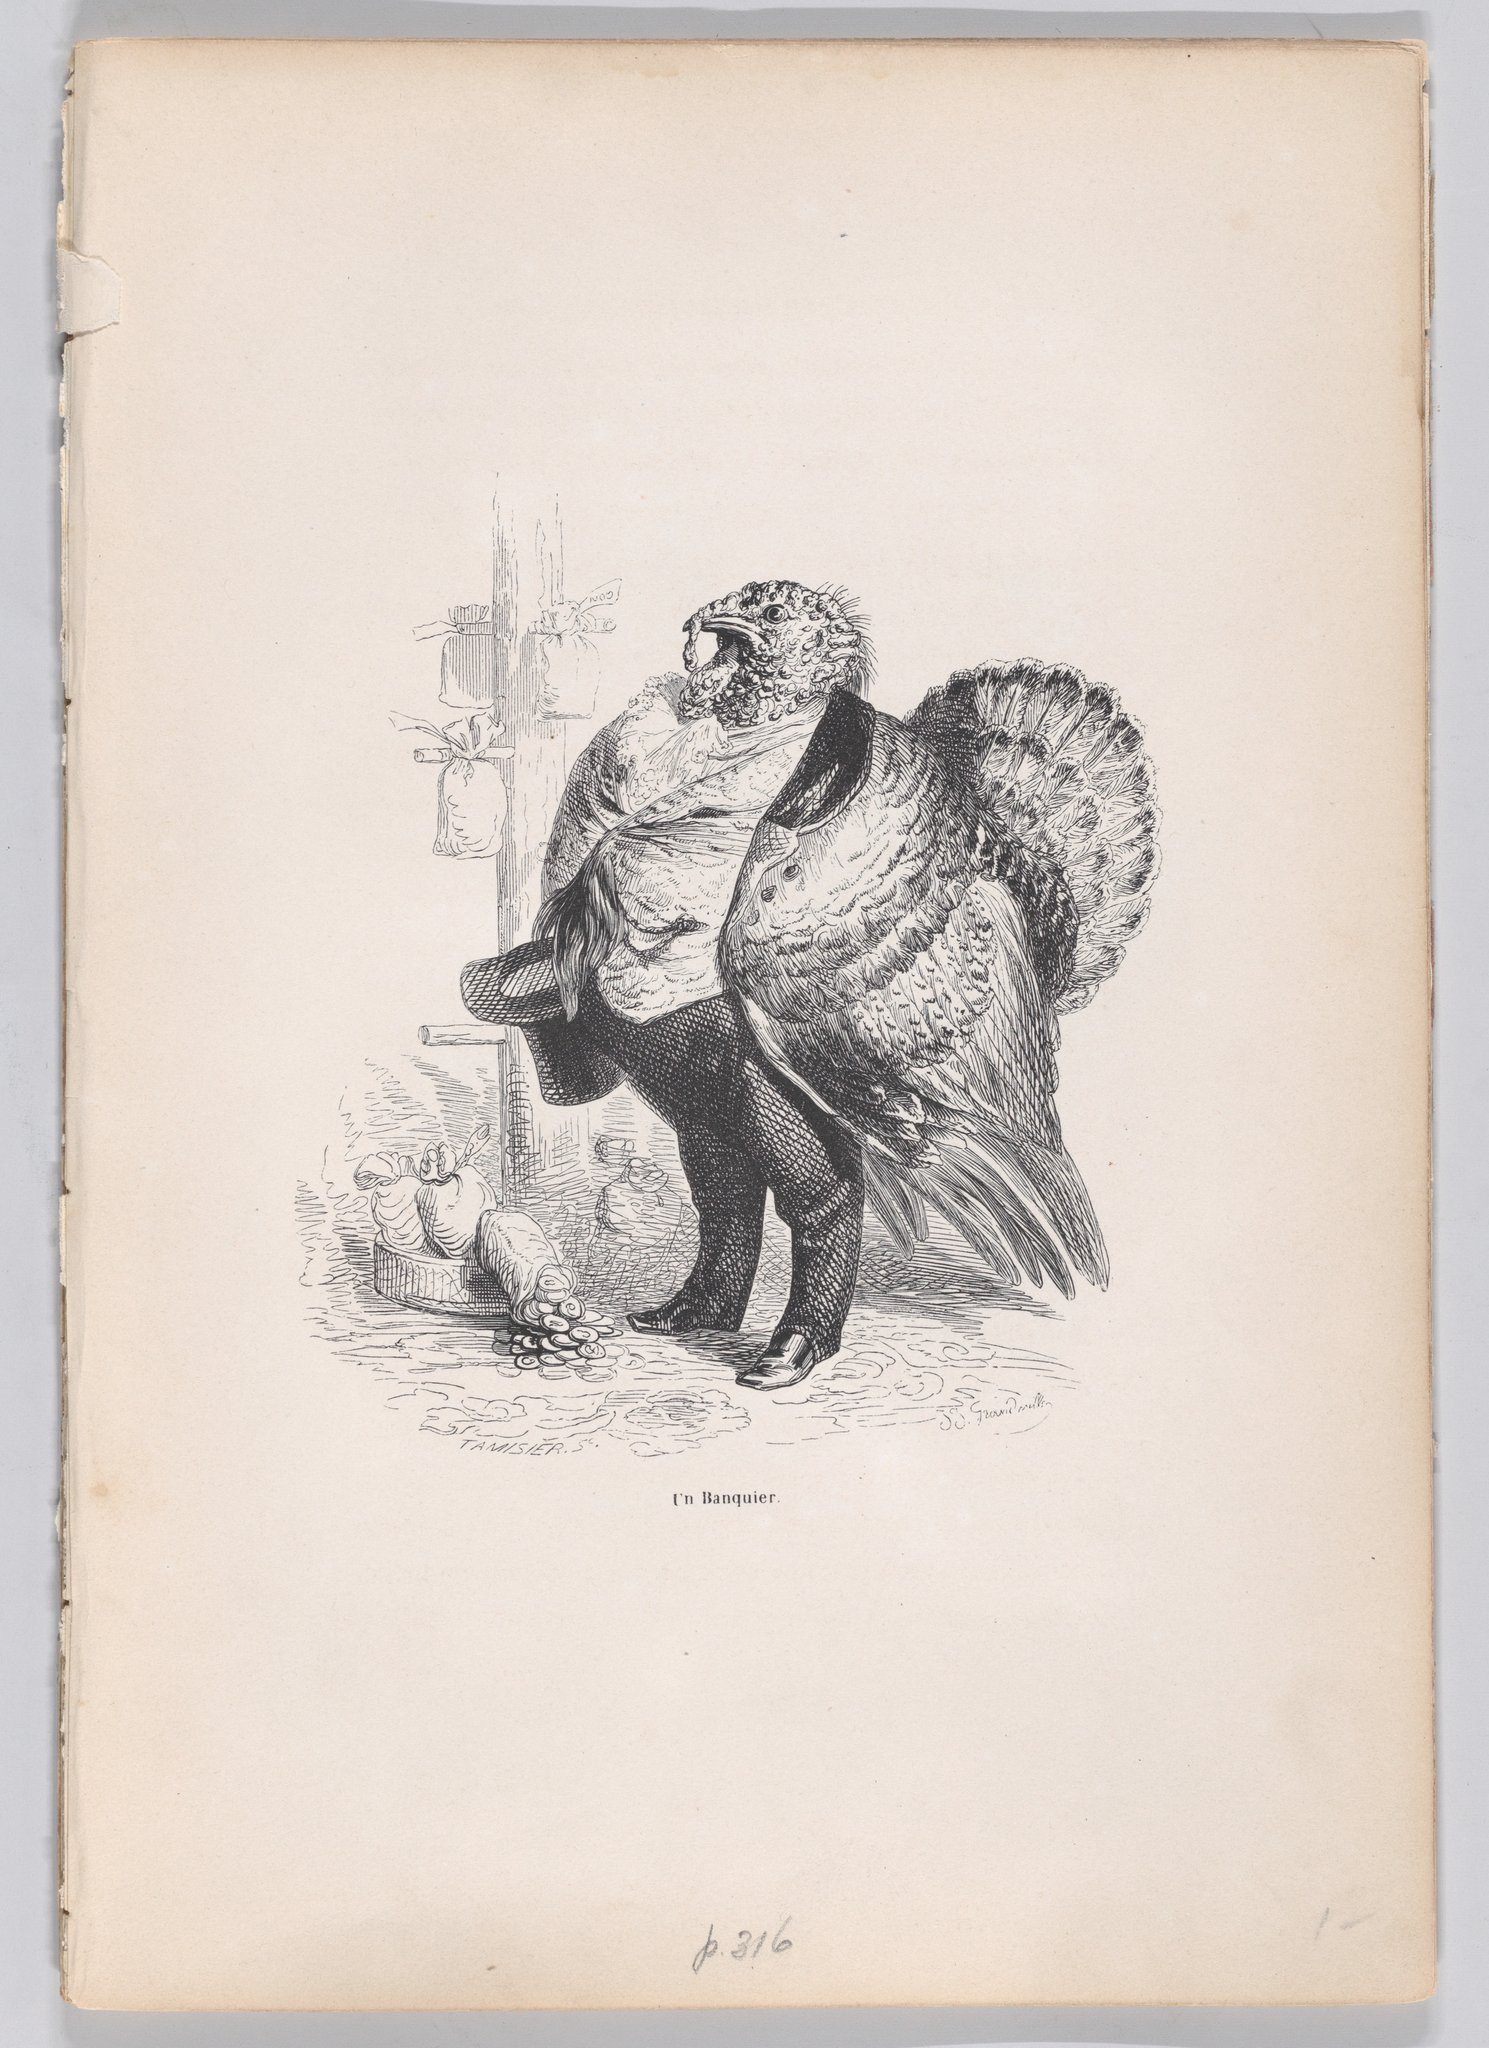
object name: print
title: A Banker, from "Scenes from the Private and Public Life of Animals"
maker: j. j. grandville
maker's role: illustrator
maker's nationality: french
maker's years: 1803-1847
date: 1837-1847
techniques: engraving